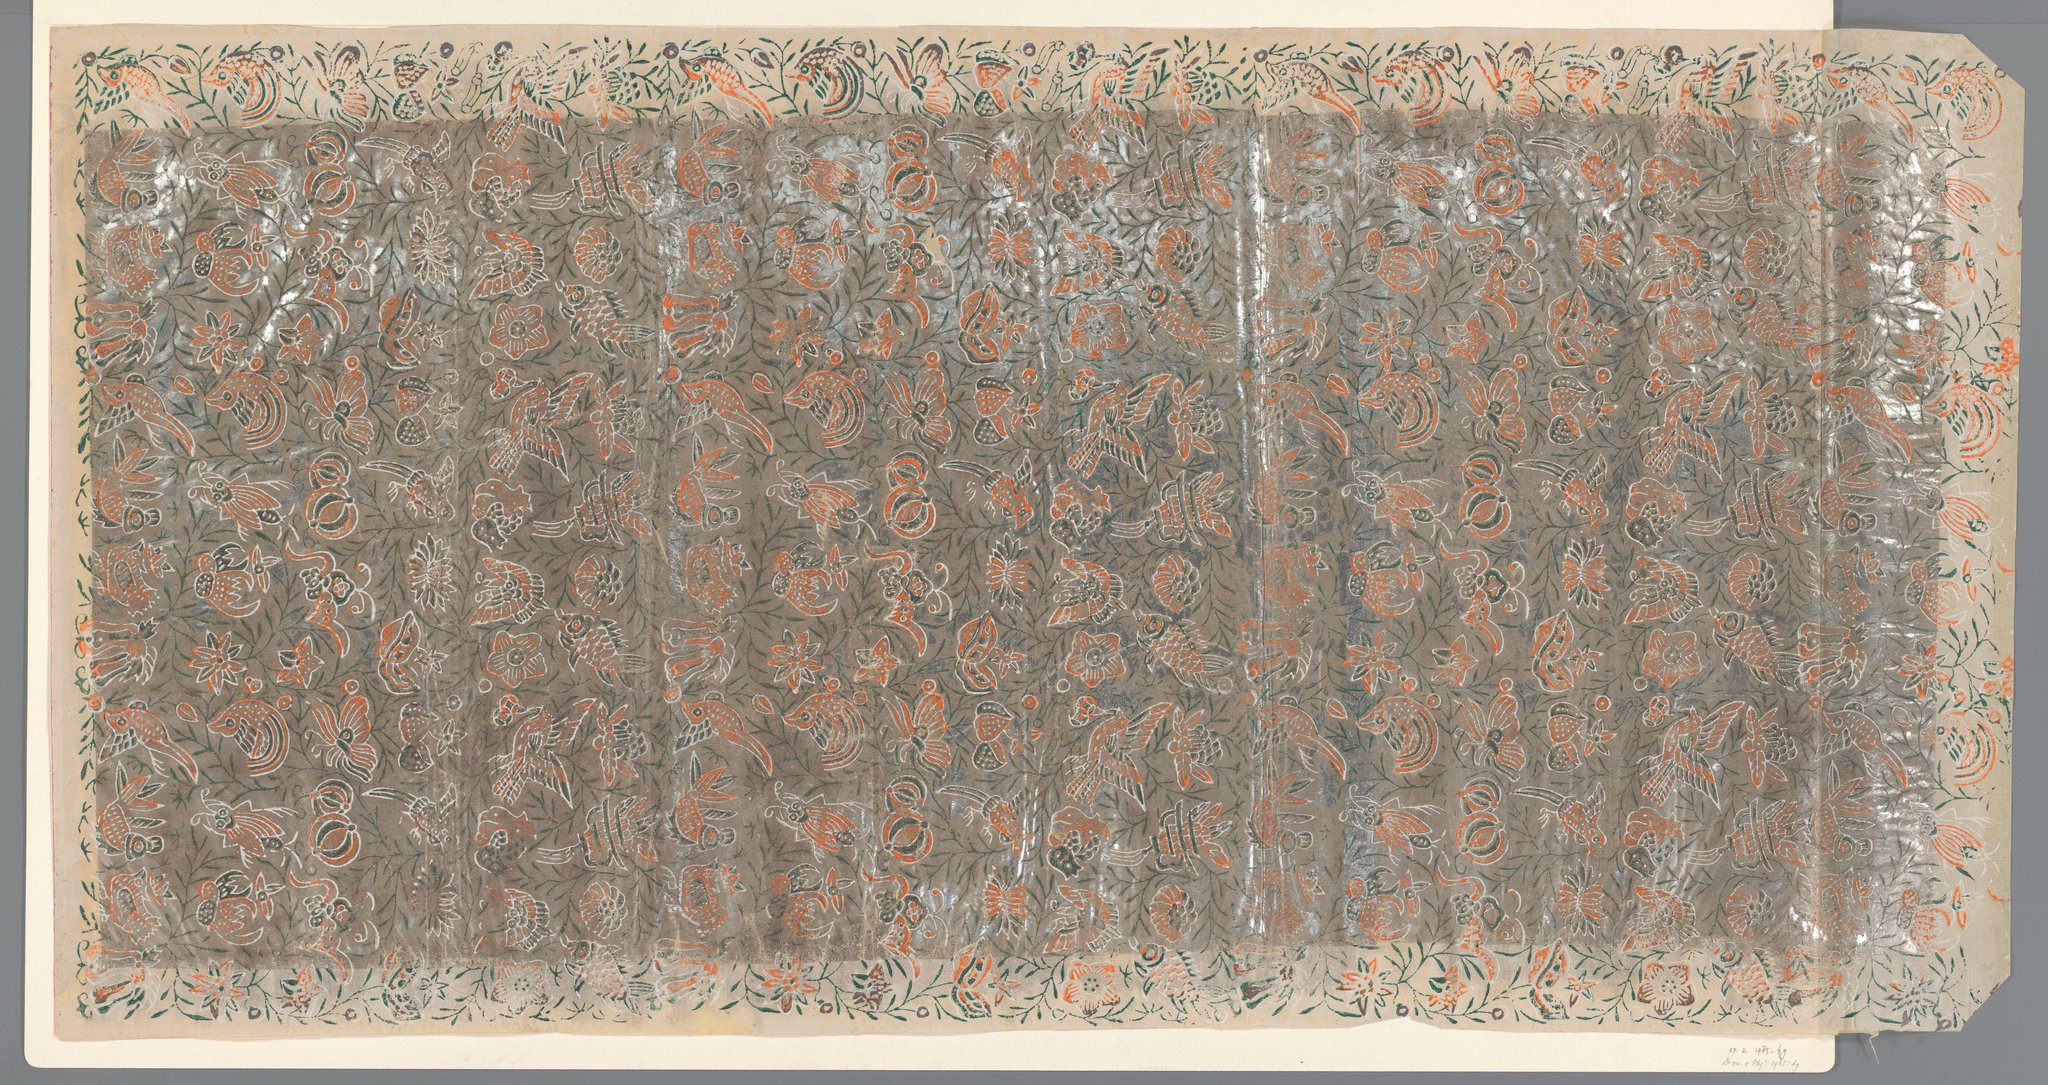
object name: decorated paper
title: Blad met strooipatroon van bloemen, vogels, vissen en insecten tussen ranken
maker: Anonymous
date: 1900-1985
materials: paper, paint, silver leaf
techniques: printing block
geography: japan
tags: ornament derived from animal forms, birds, insects, ornament derived from plant forms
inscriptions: collector's mark: Lugt 2228